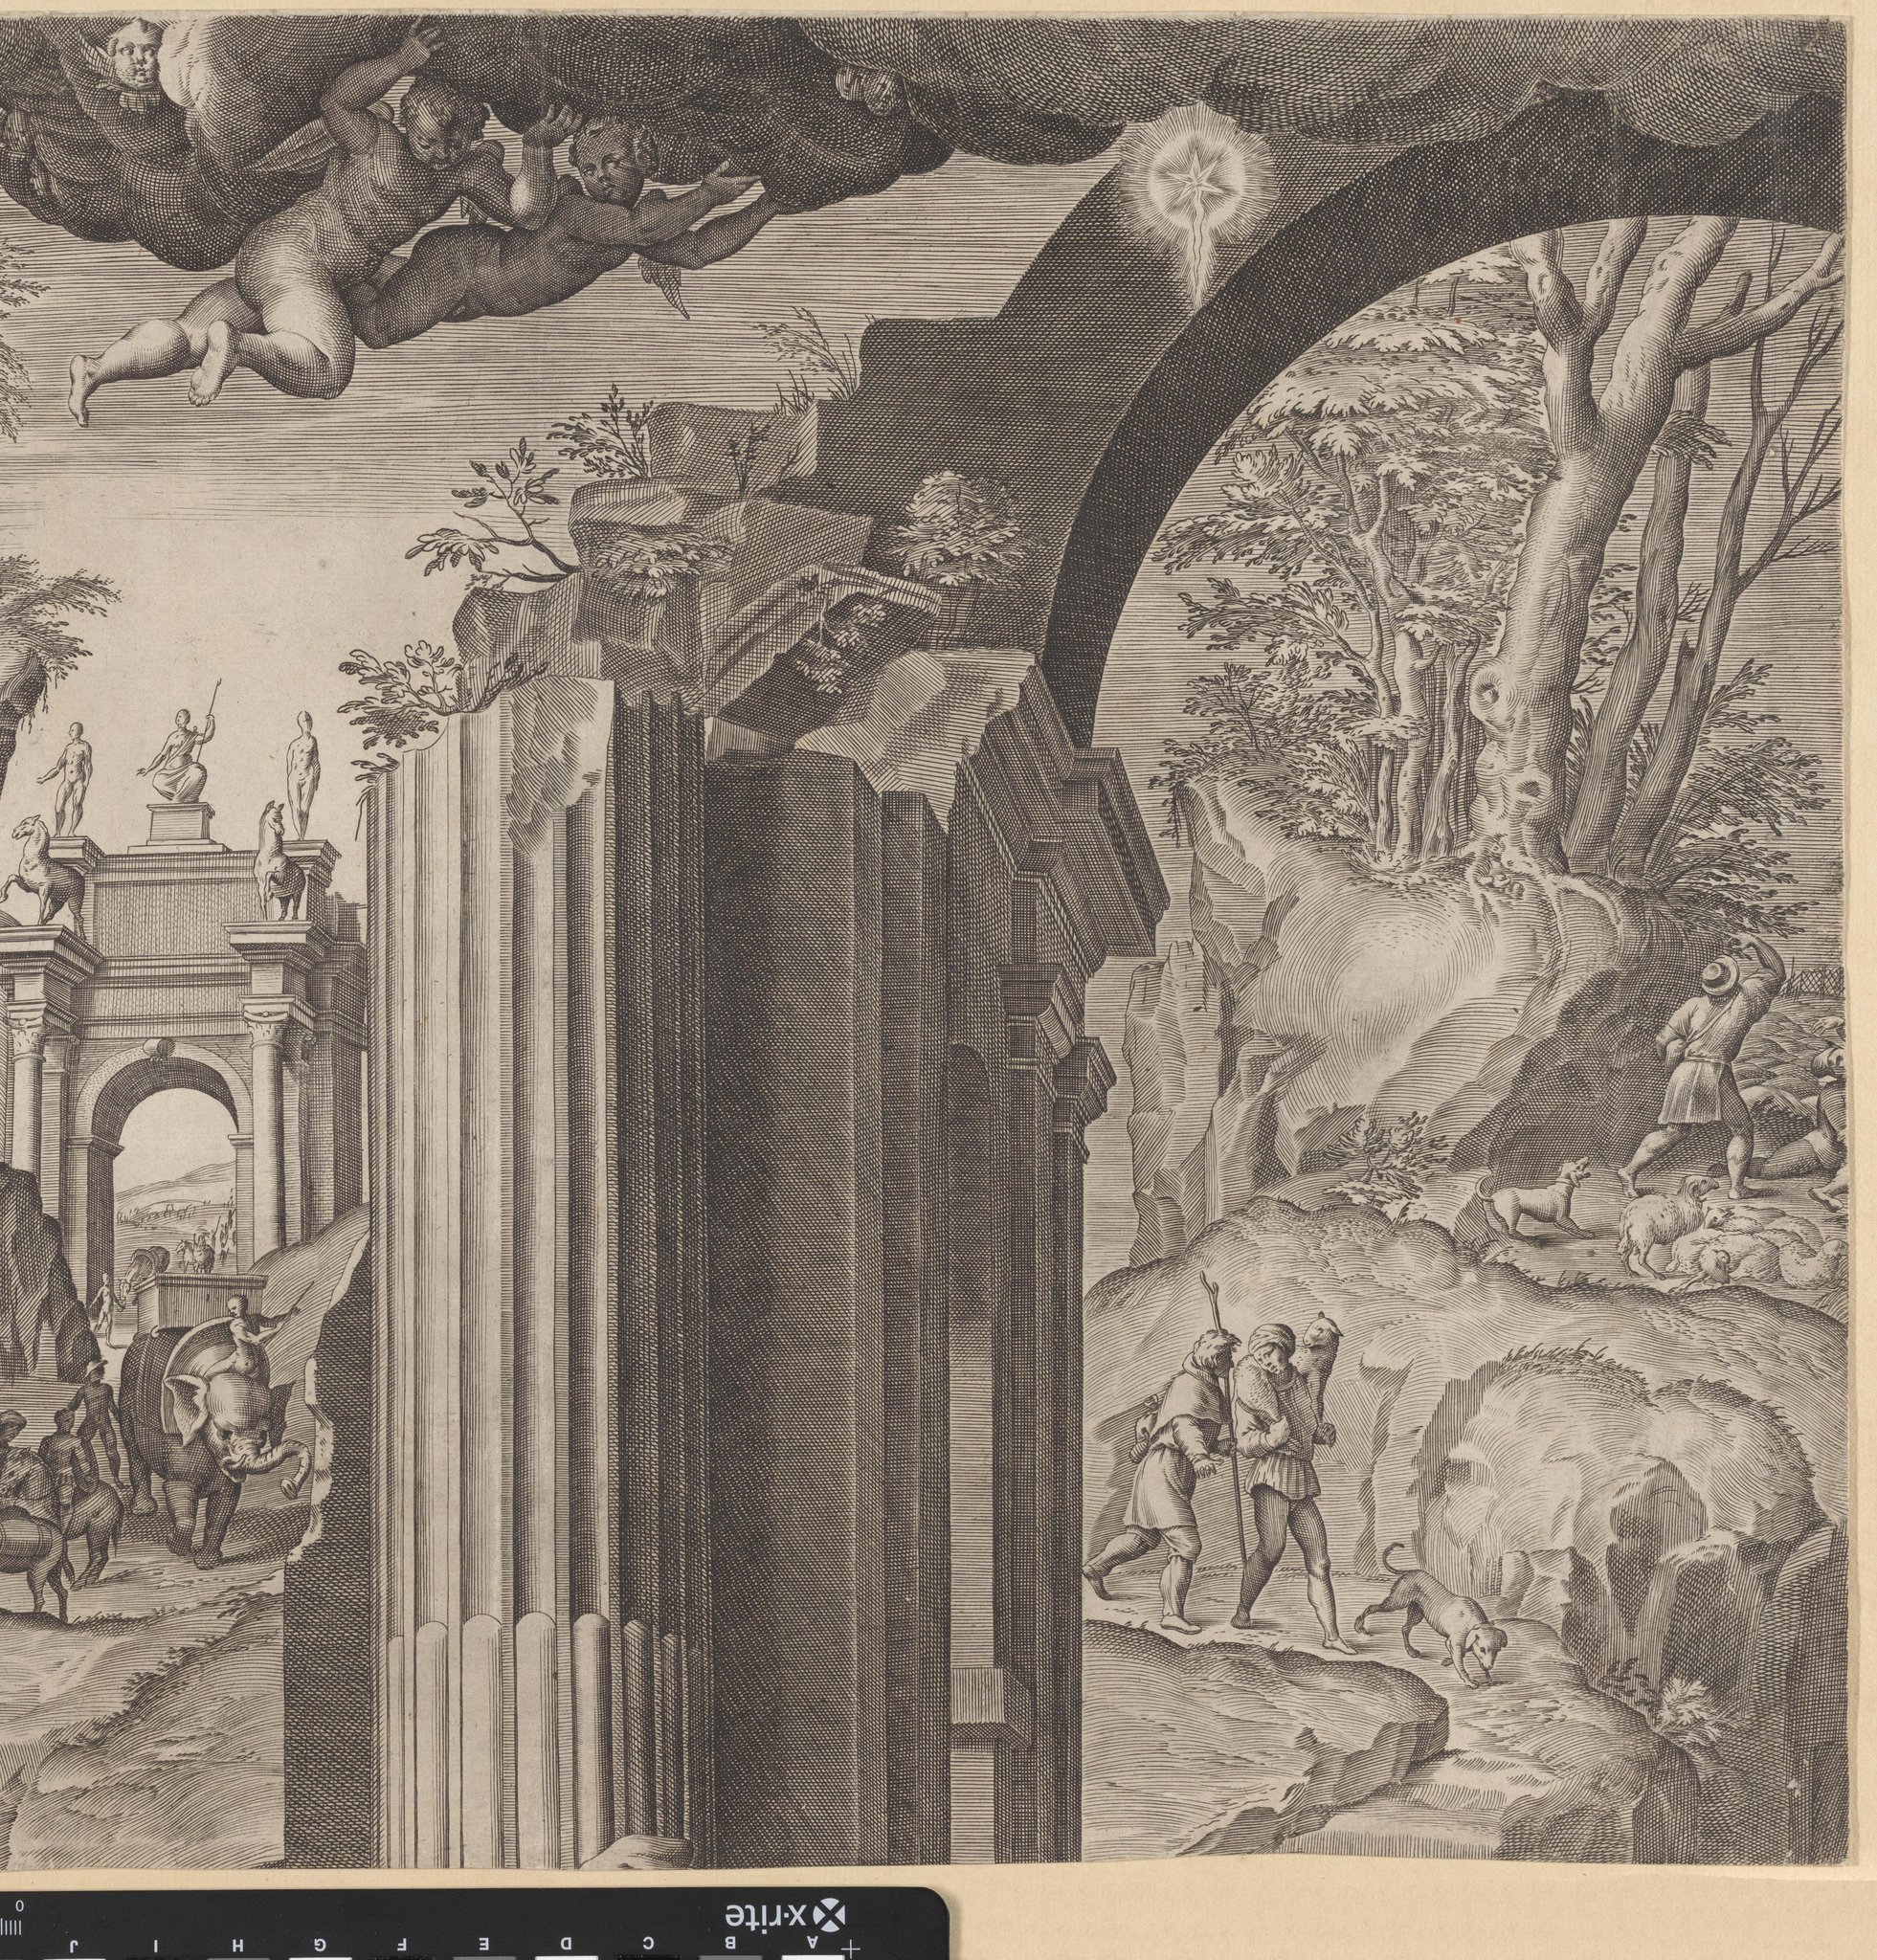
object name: print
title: Aanbidding door de koningen (deel linksboven)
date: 1567-1602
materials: paper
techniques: engraving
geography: italy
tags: adoration of the kings: the wise men present their gifts to the christ-child (gold, frankincense and myrrh)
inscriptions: collector's mark: Lugt 240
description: Deze prent is onderdeel van een grote prent gedrukt van zeven platen op zeven bladen die aan elkaar gemonteerd moesten worden. In de collectie van het Rijksmuseum bevinden zich vier van de zeven delen. Naar een tekening door Peruzzi in het British Museum te Londen.